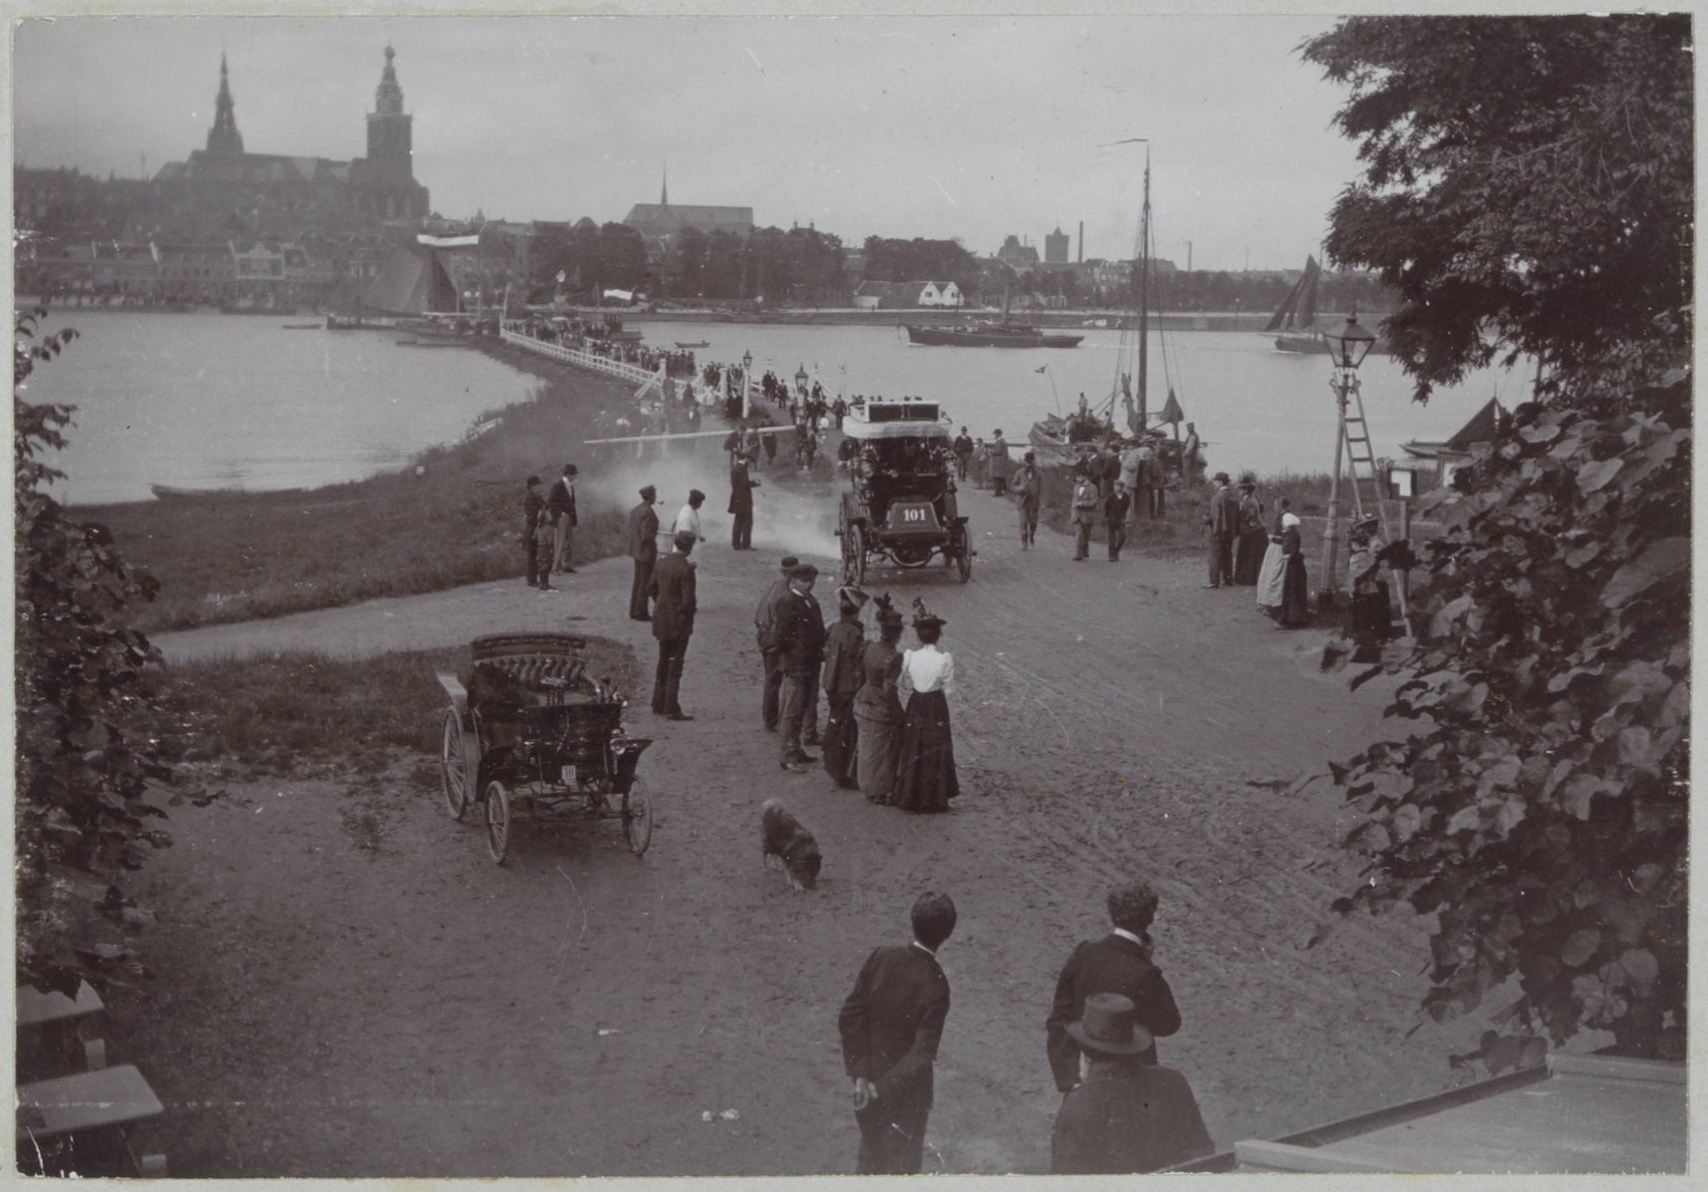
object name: photograph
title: Deelnemers aan de race Parijs-Amsterdam passeren in hun automobielen een pontonbrug te Nijmegen, gadegeslagen door het publiek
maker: delizy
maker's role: manufacturer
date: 1807-1898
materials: paper, photographic support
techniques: collodion silver print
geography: nijmegen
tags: motorcar racing, pontoon bridge, automobile, nijmegen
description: Onderdeel van Fotoalbum van een Franse amateurfotograaf met opnames van uitstapjes in Frankrijk, Spanje, België, Luxemburg en Nederland, de eerste automobielen en autoraces.